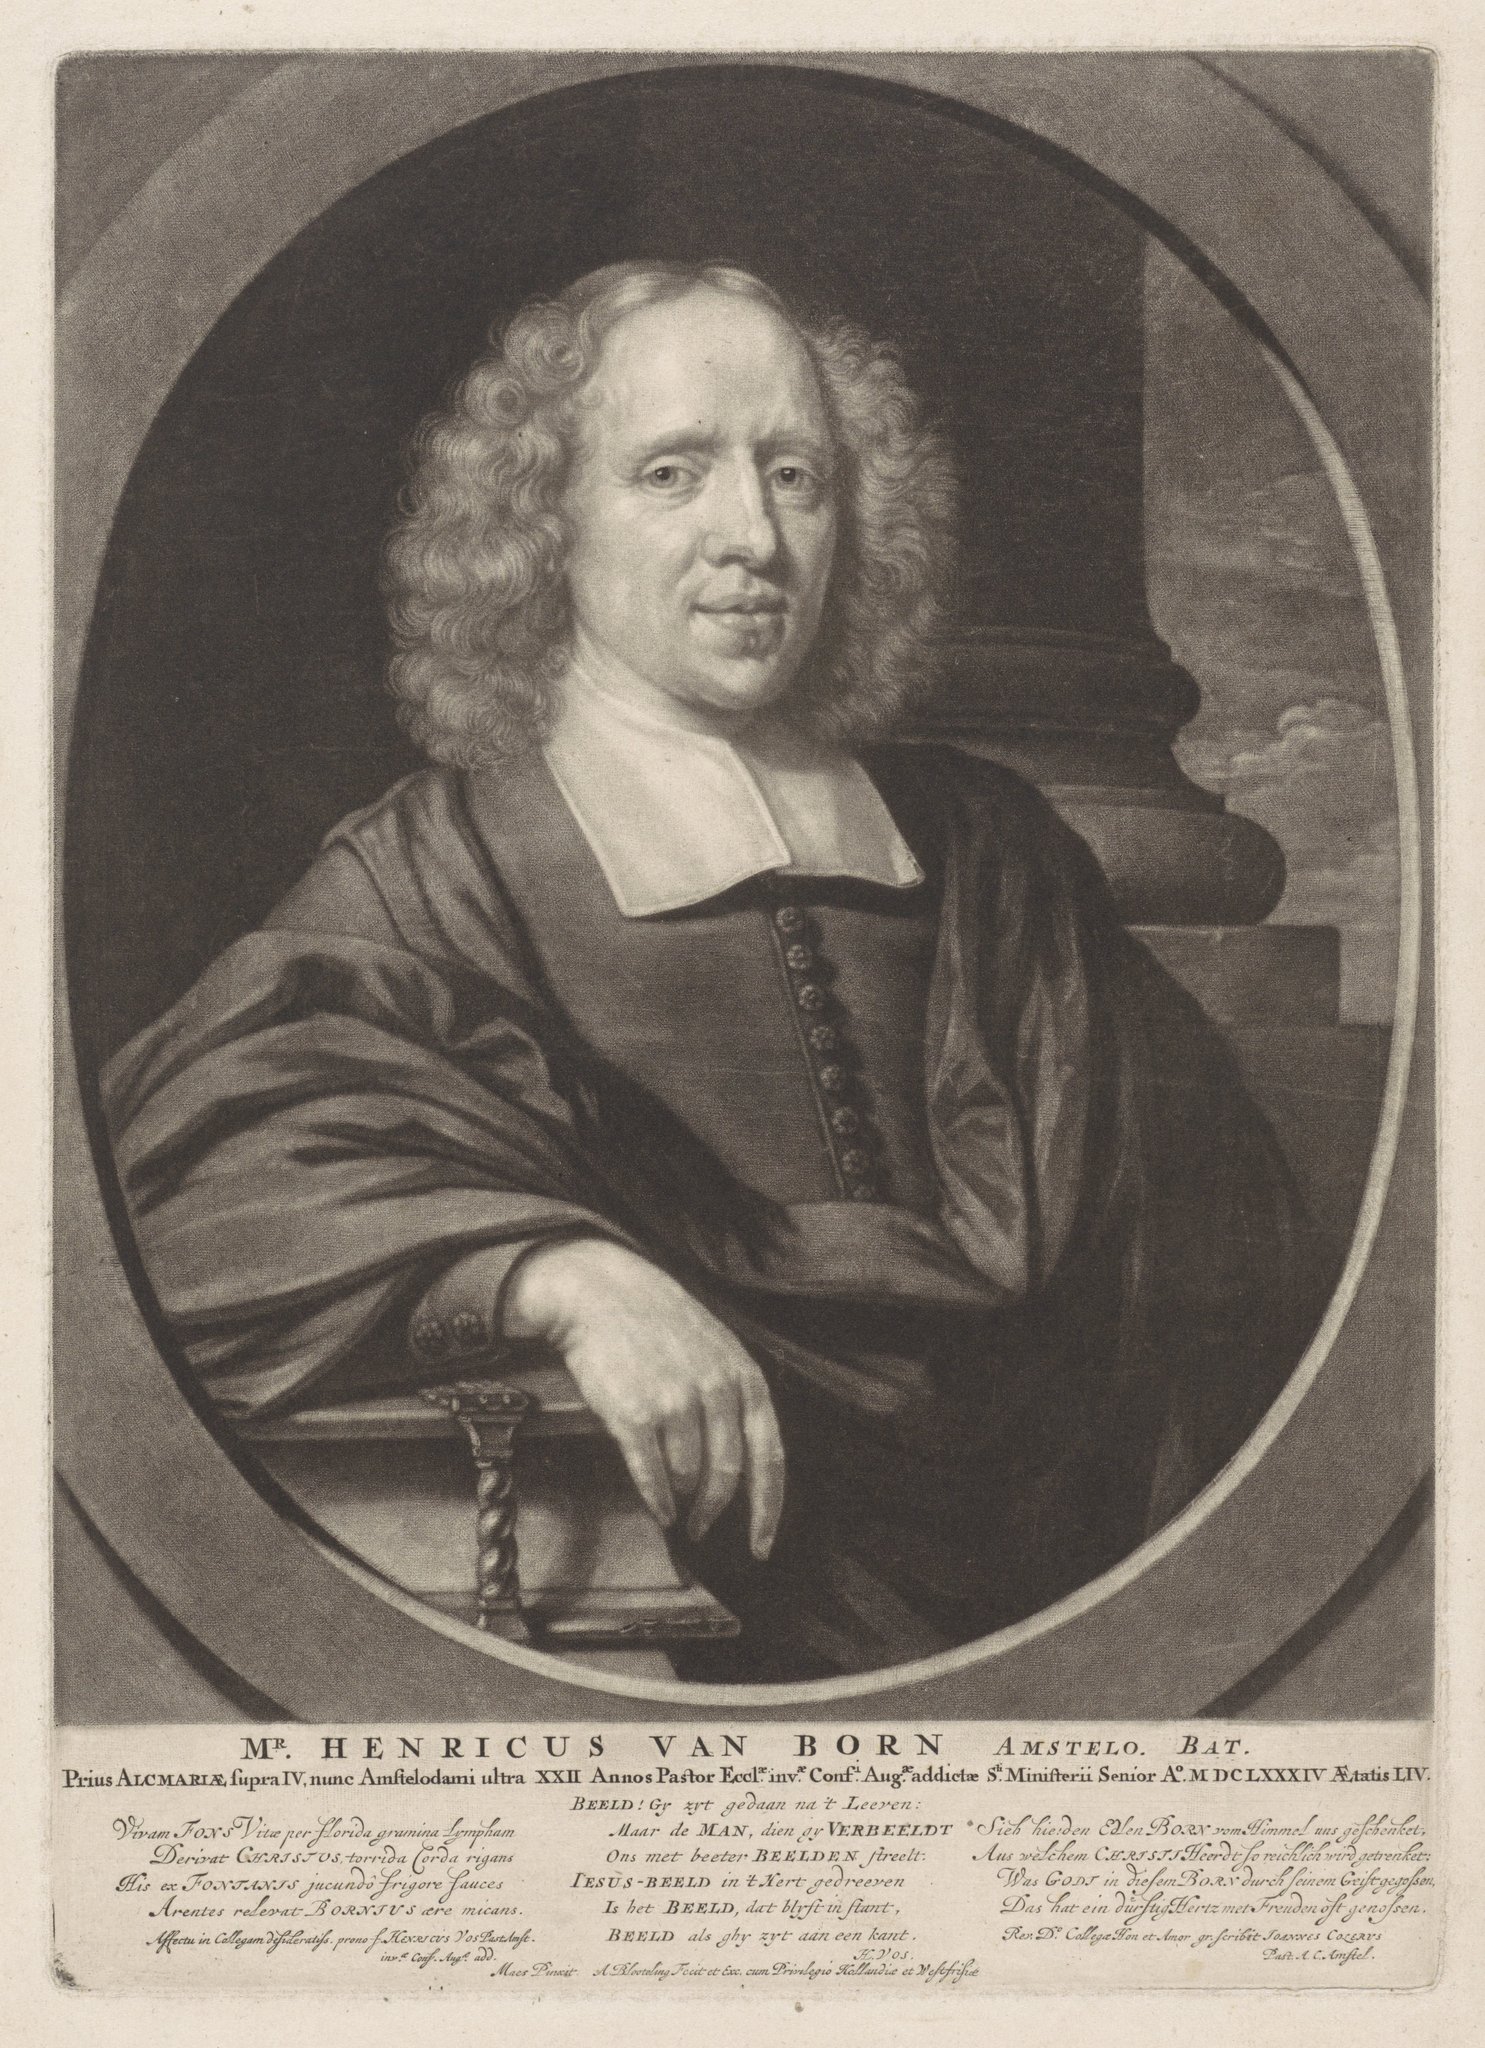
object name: print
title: Portret van Henricus van Born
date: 1684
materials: paper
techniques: engraving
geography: amsterdam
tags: amsterdam, henricus van born, bible, theologian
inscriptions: collector's mark: Lugt 2228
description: Portret van Henricus van Born, theoloog te Amsterdam. Zijn arm rust op de bijbel.